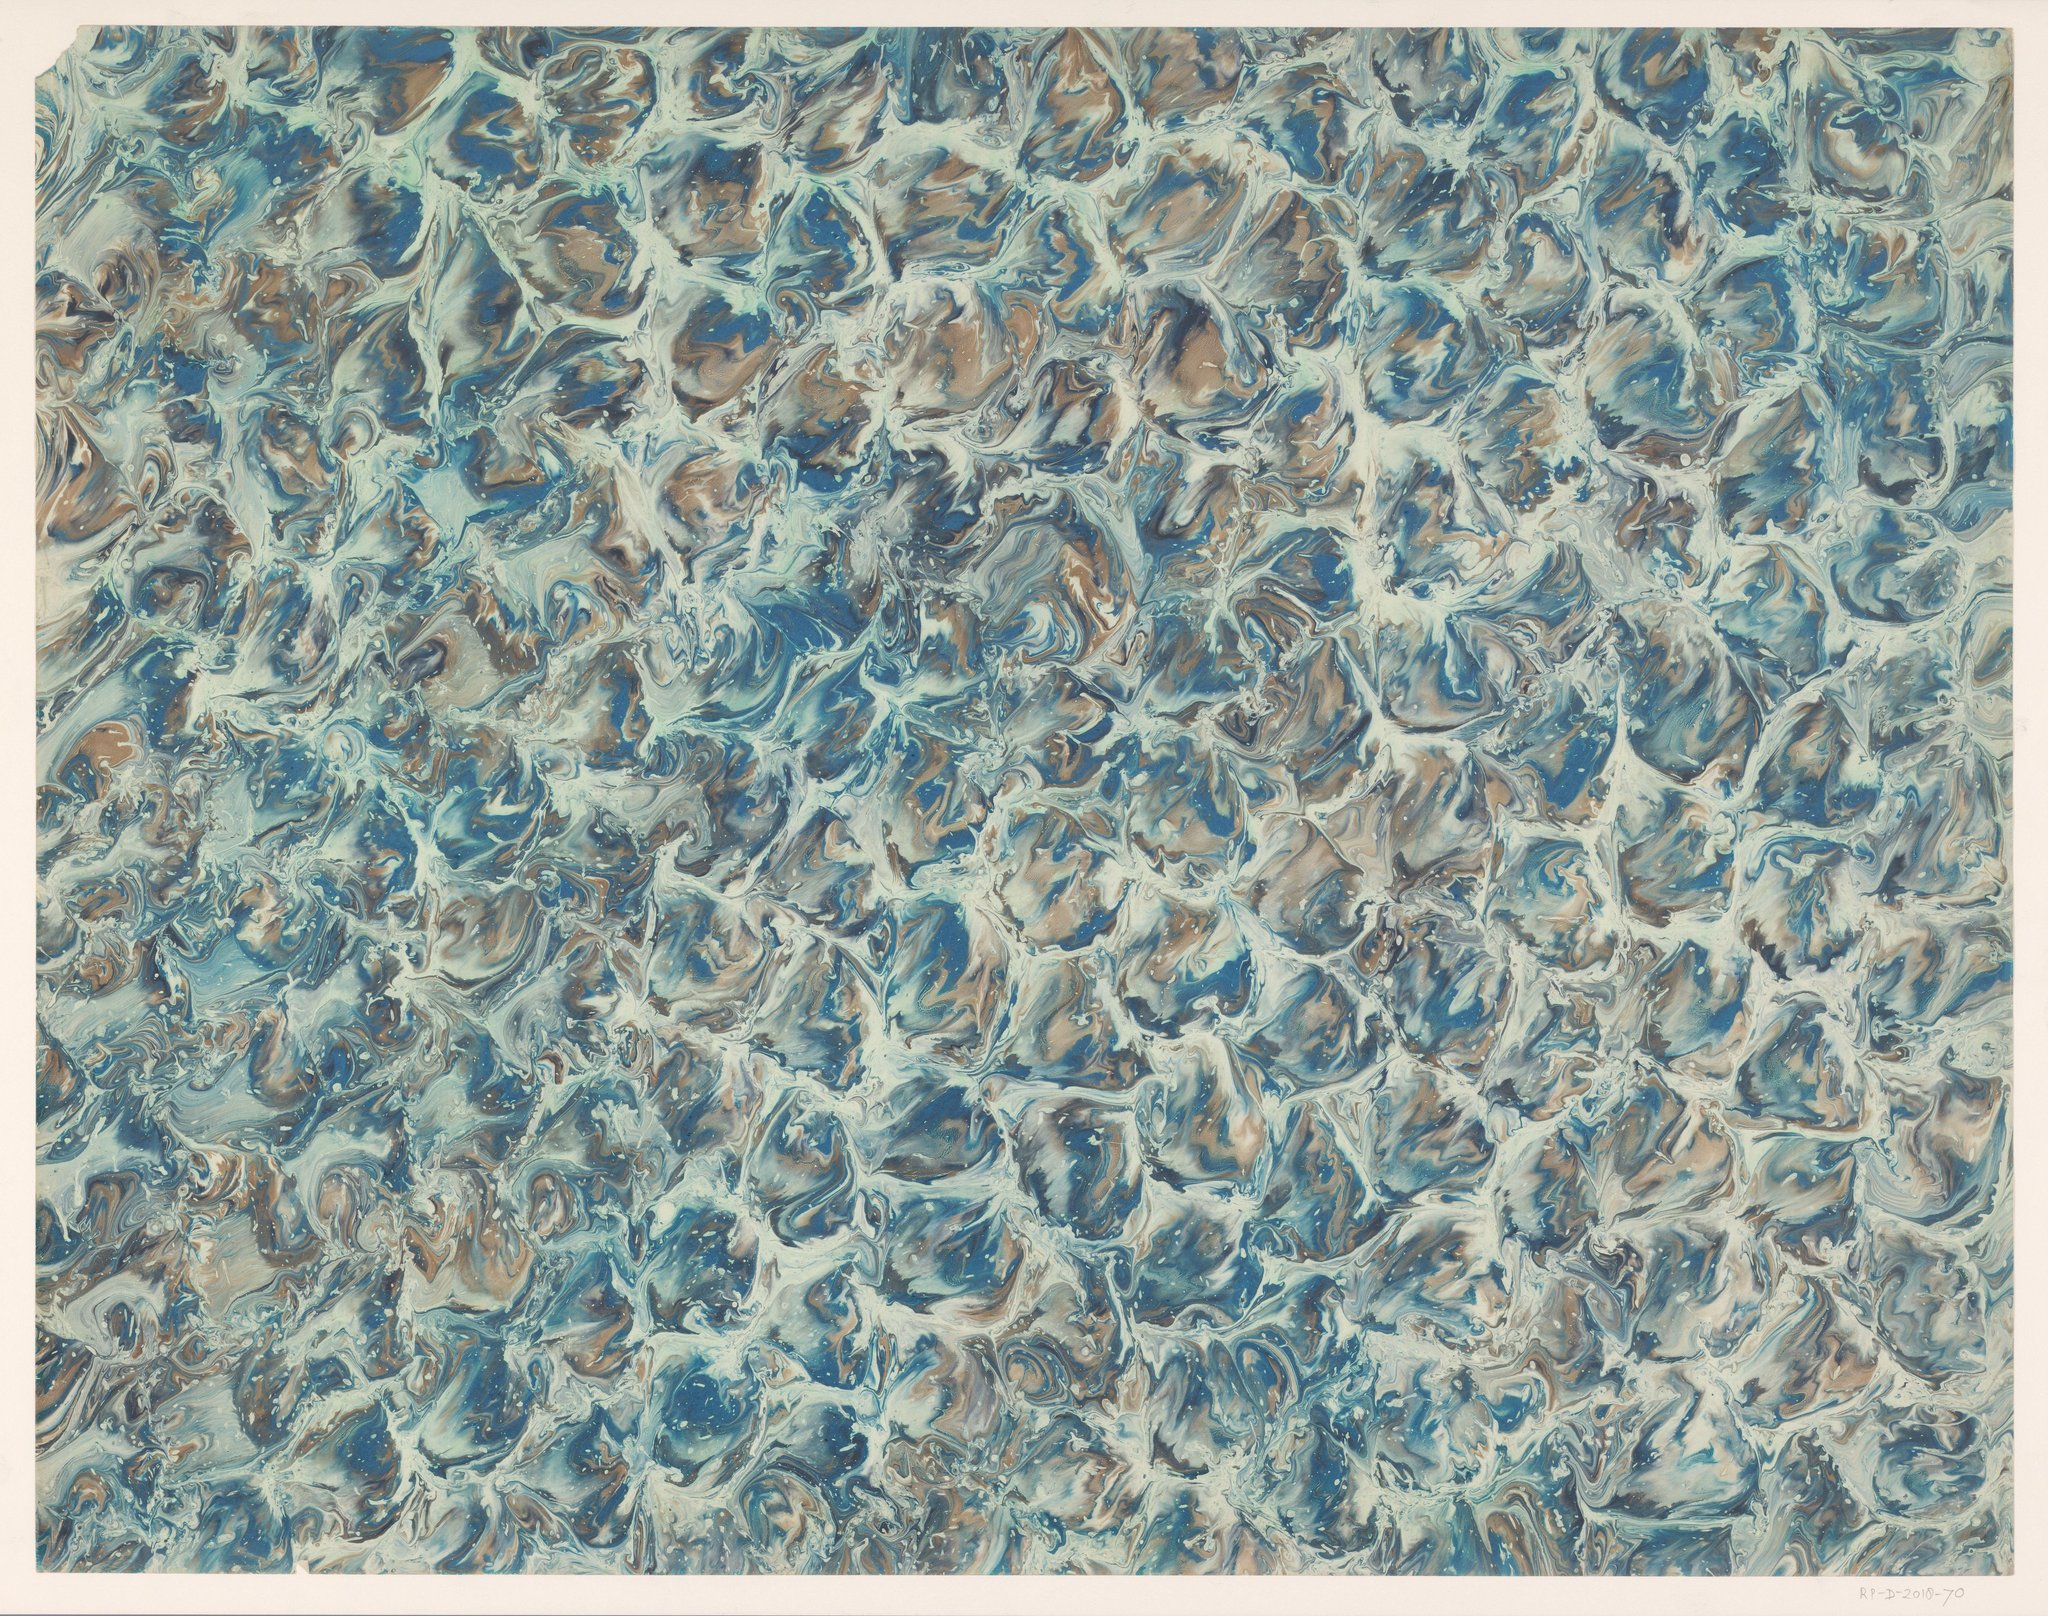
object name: marbled paper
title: Fantasiemarmer in verschillende tinten blauw en bruin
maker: Anonymous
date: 1900-2000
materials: paint, paper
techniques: marbled paper